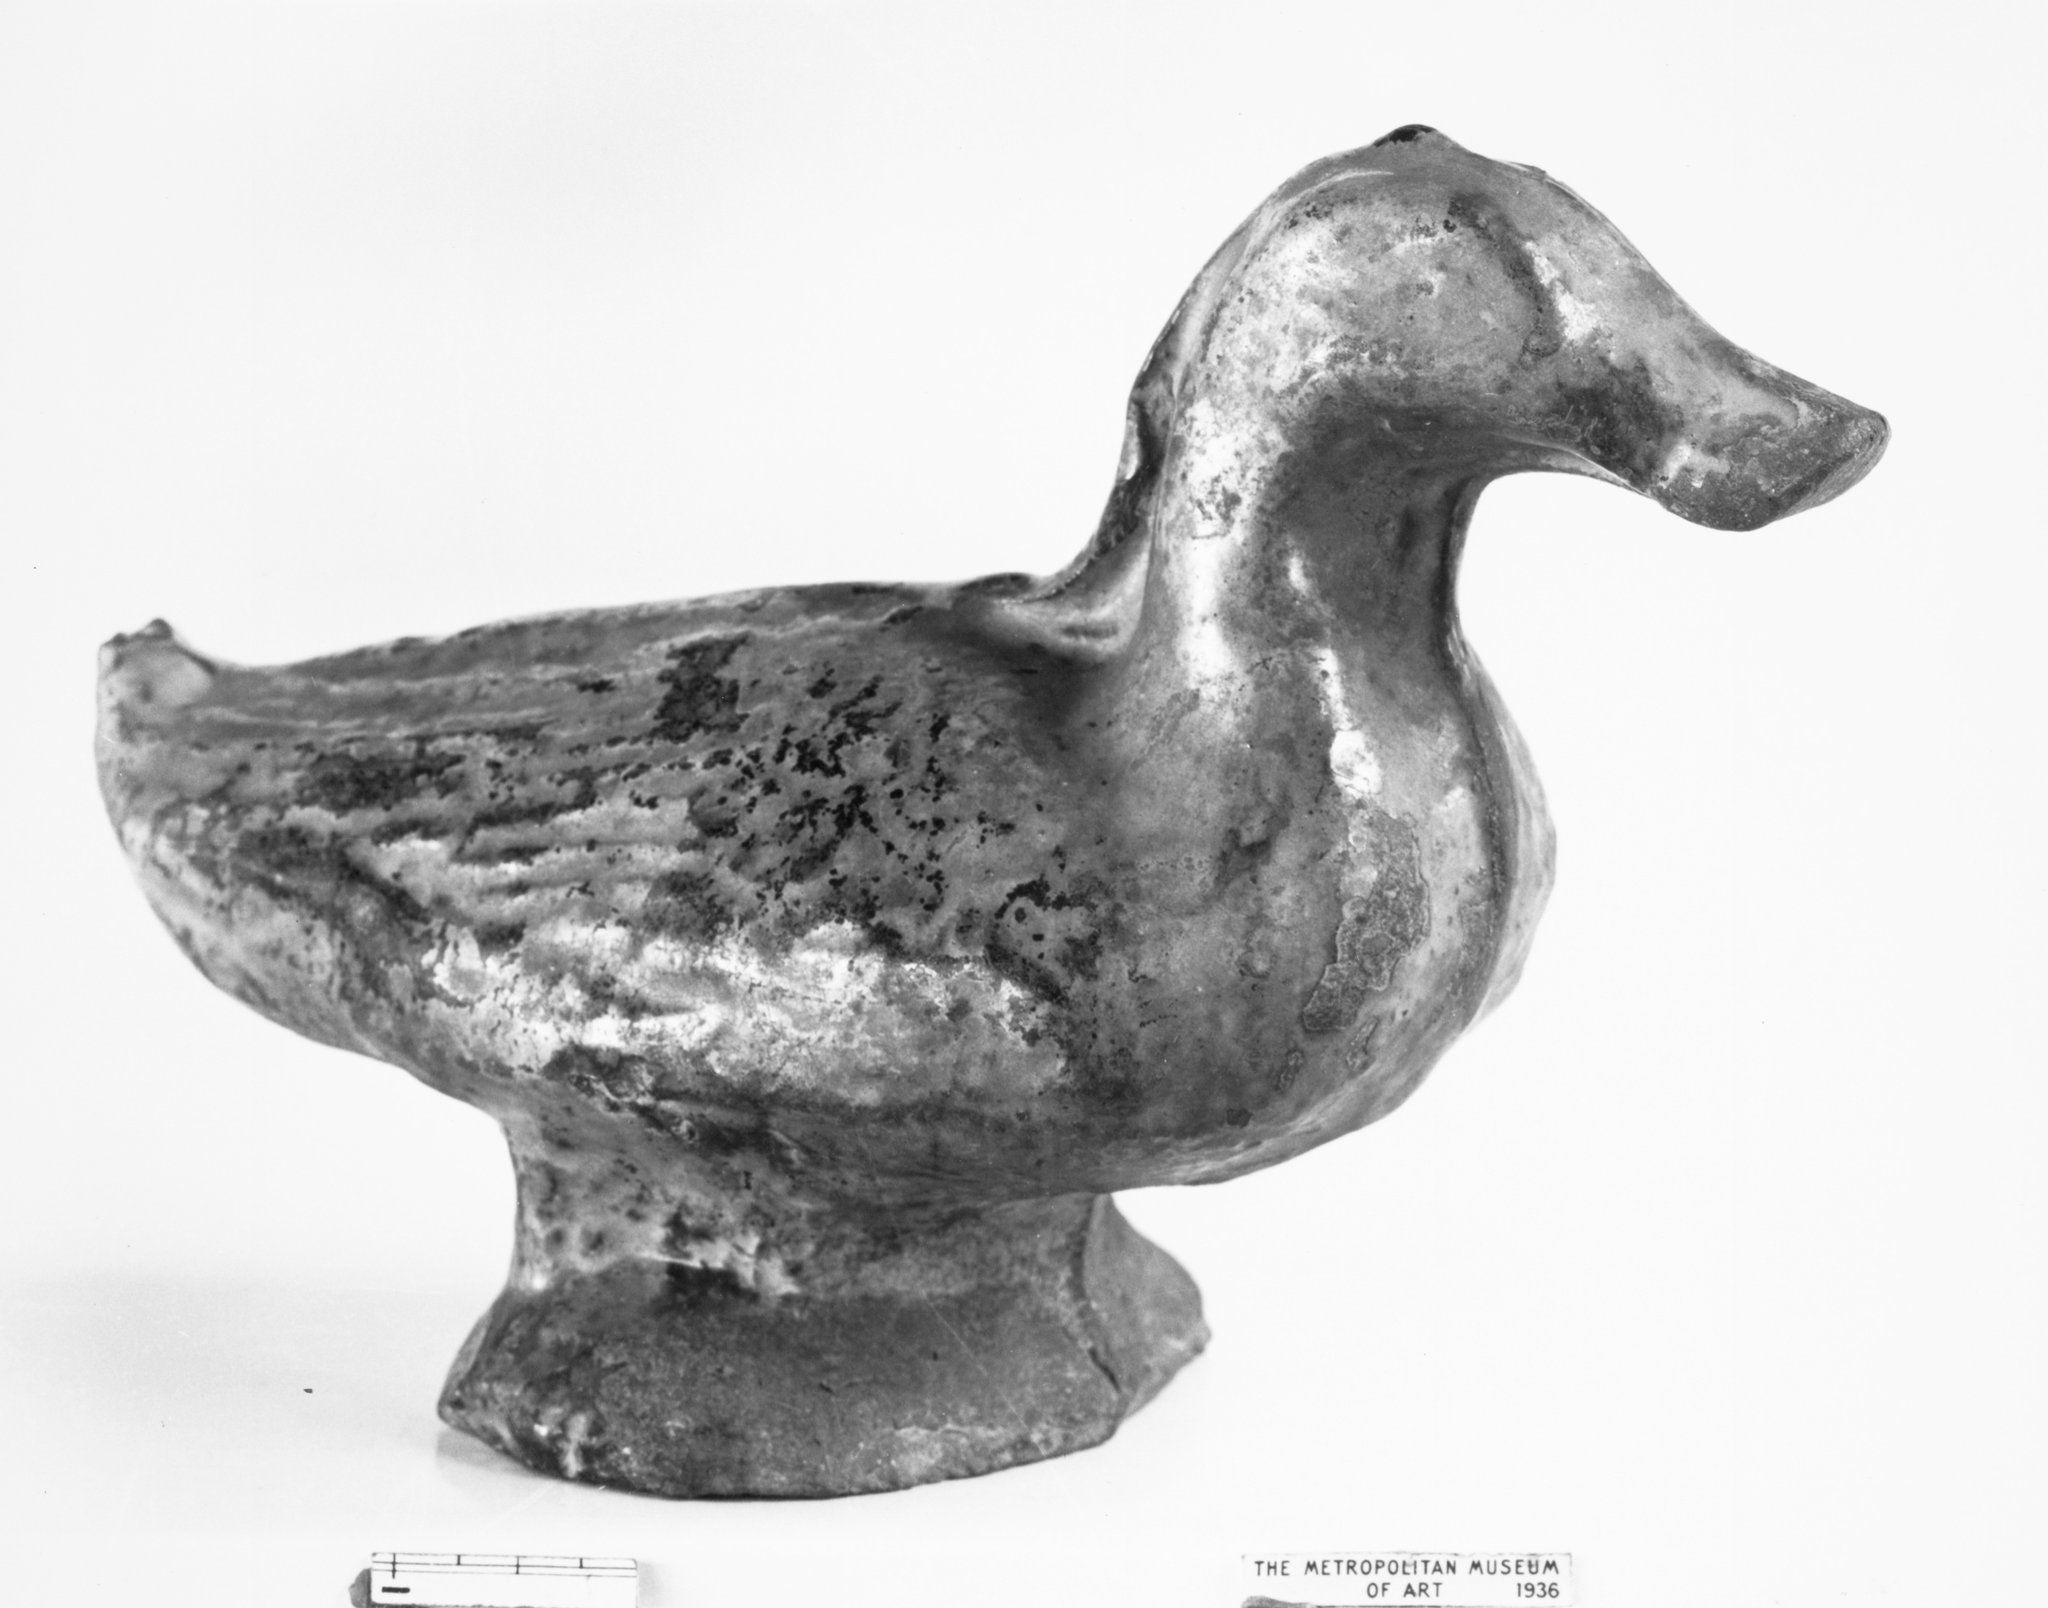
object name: figure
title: Figure of a Duck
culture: chinese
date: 206 BCE-220 CE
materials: pottery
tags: ducks